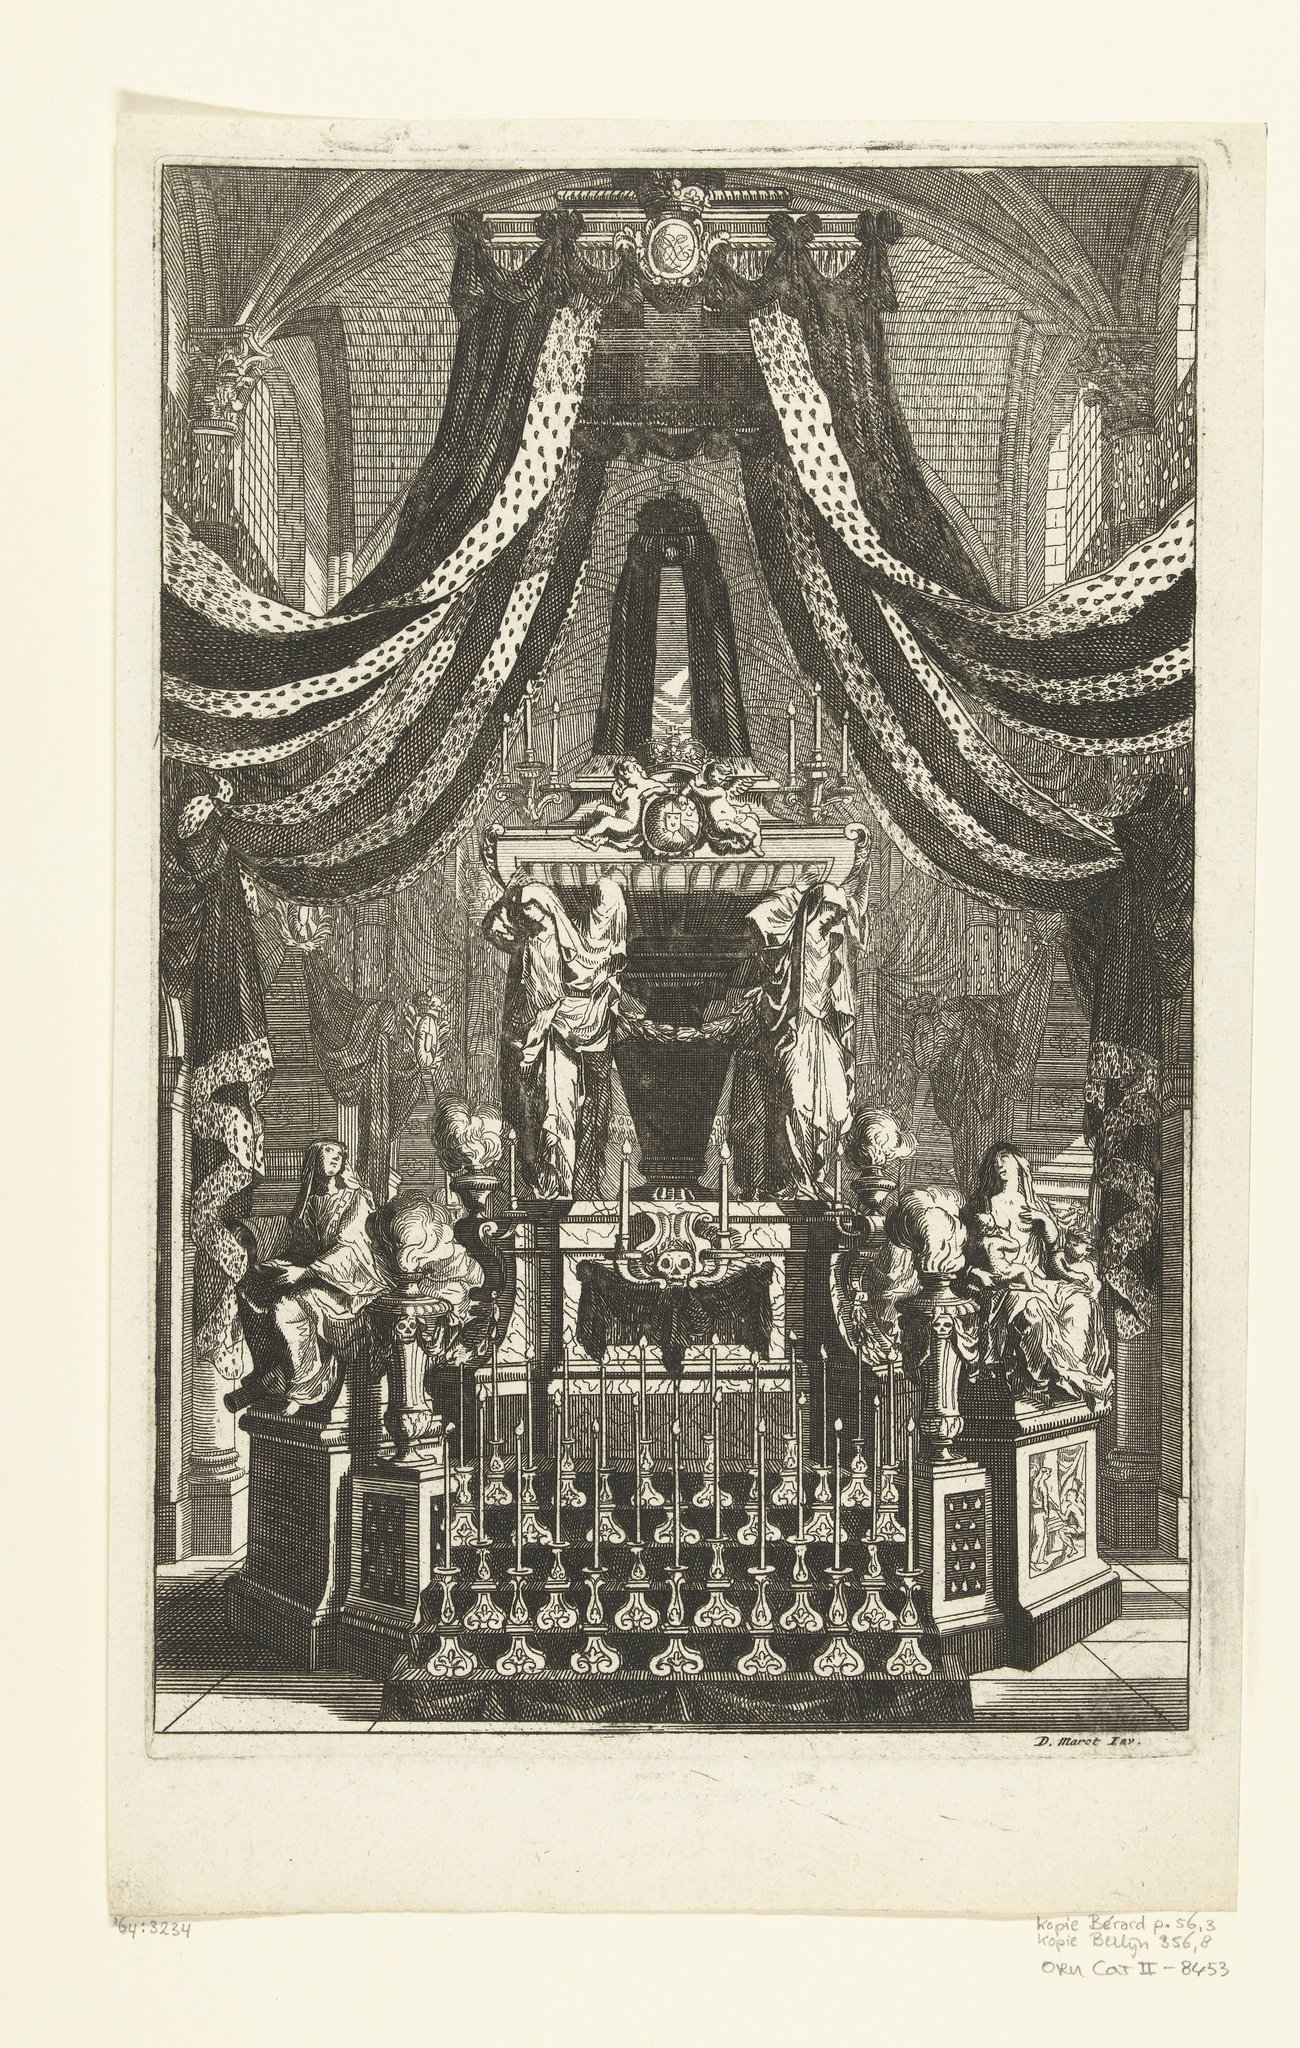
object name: print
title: Mausoleum voor William III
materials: paper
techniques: etching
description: In een kerk staat een grote tombe ondersteund door vier gesluierde vrouwen. Op de voorgrond staan vier rijen kaarsen.